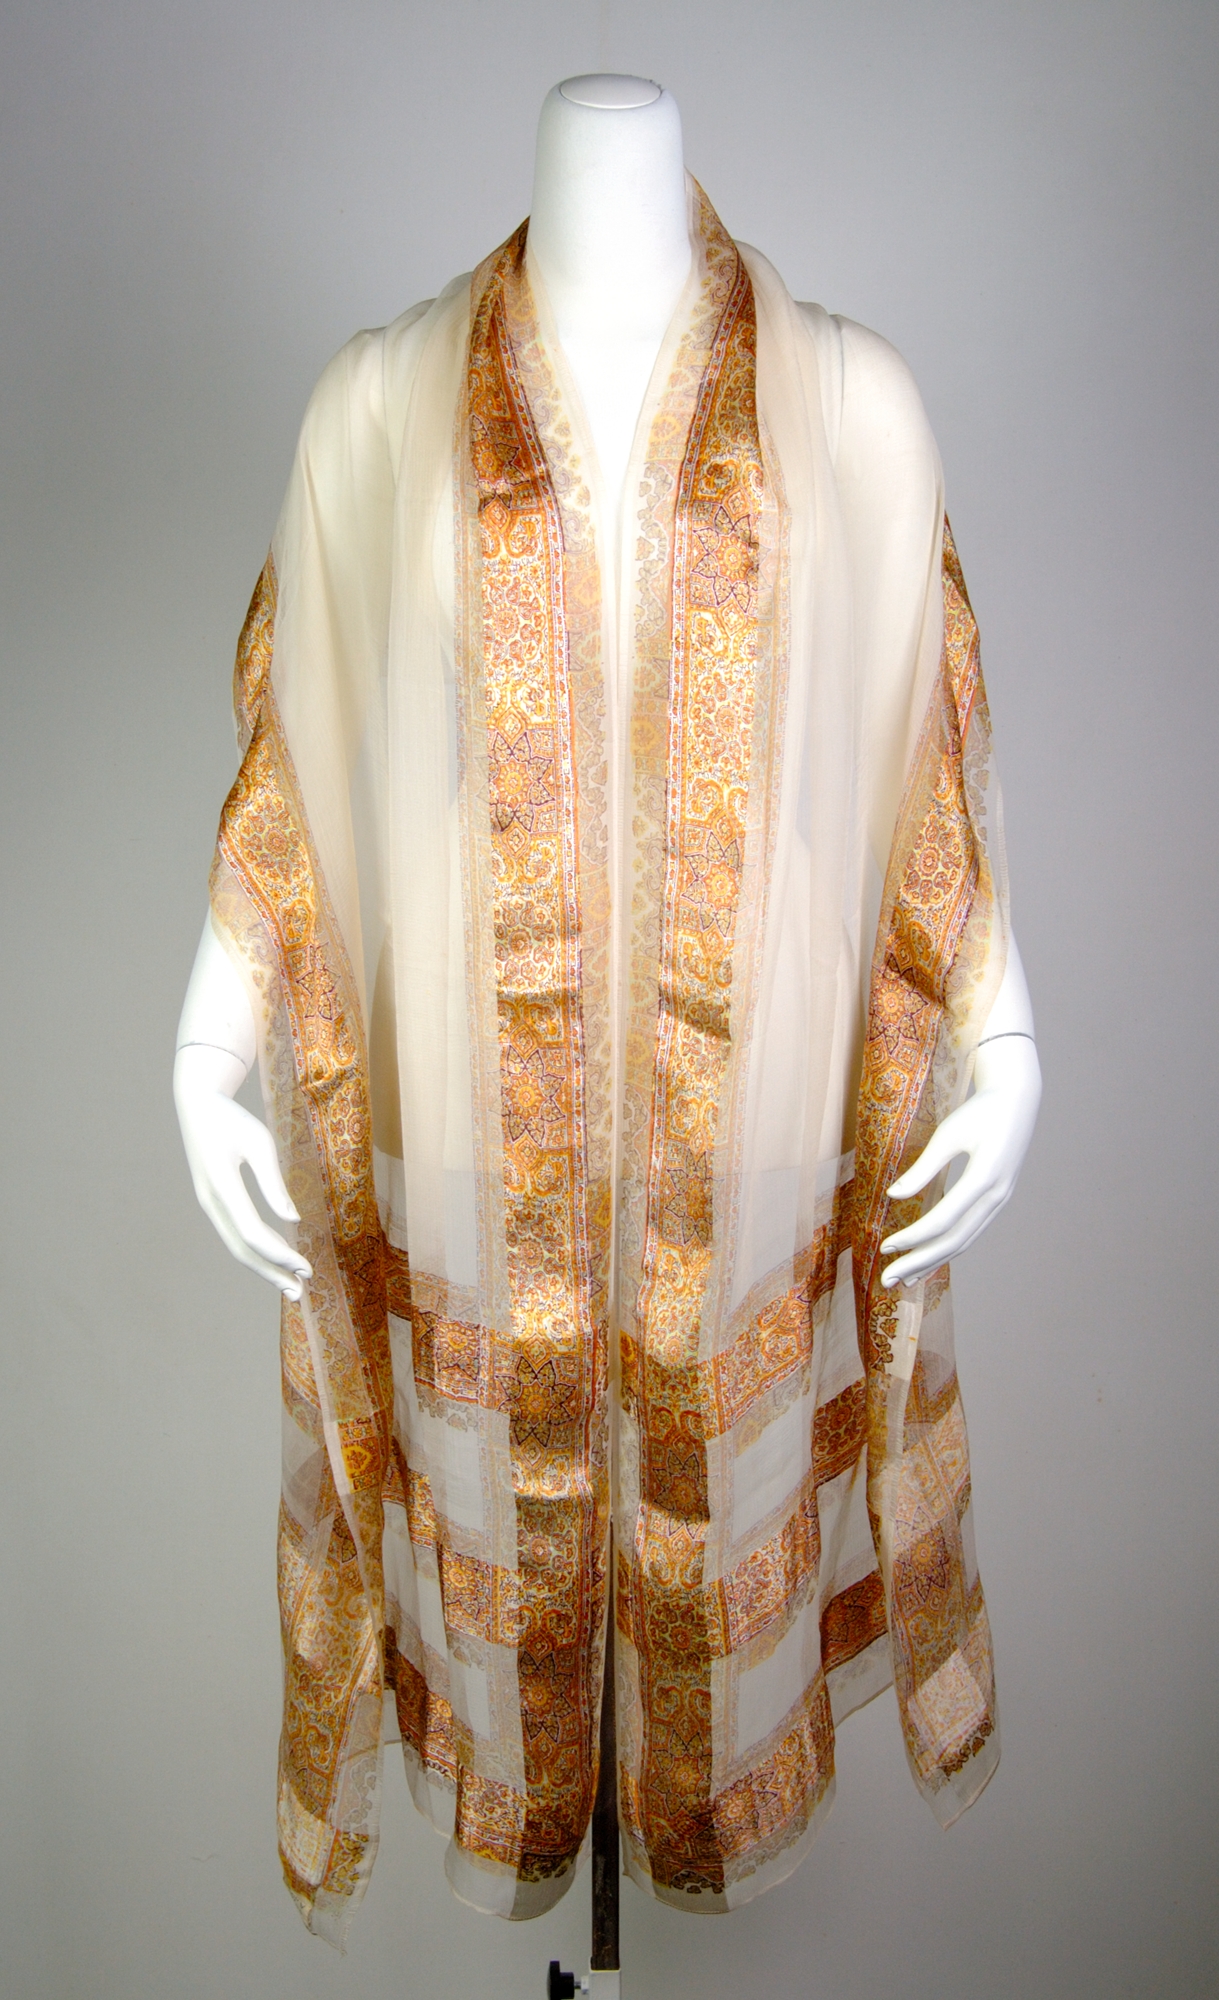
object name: stole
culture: american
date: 1895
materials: silk